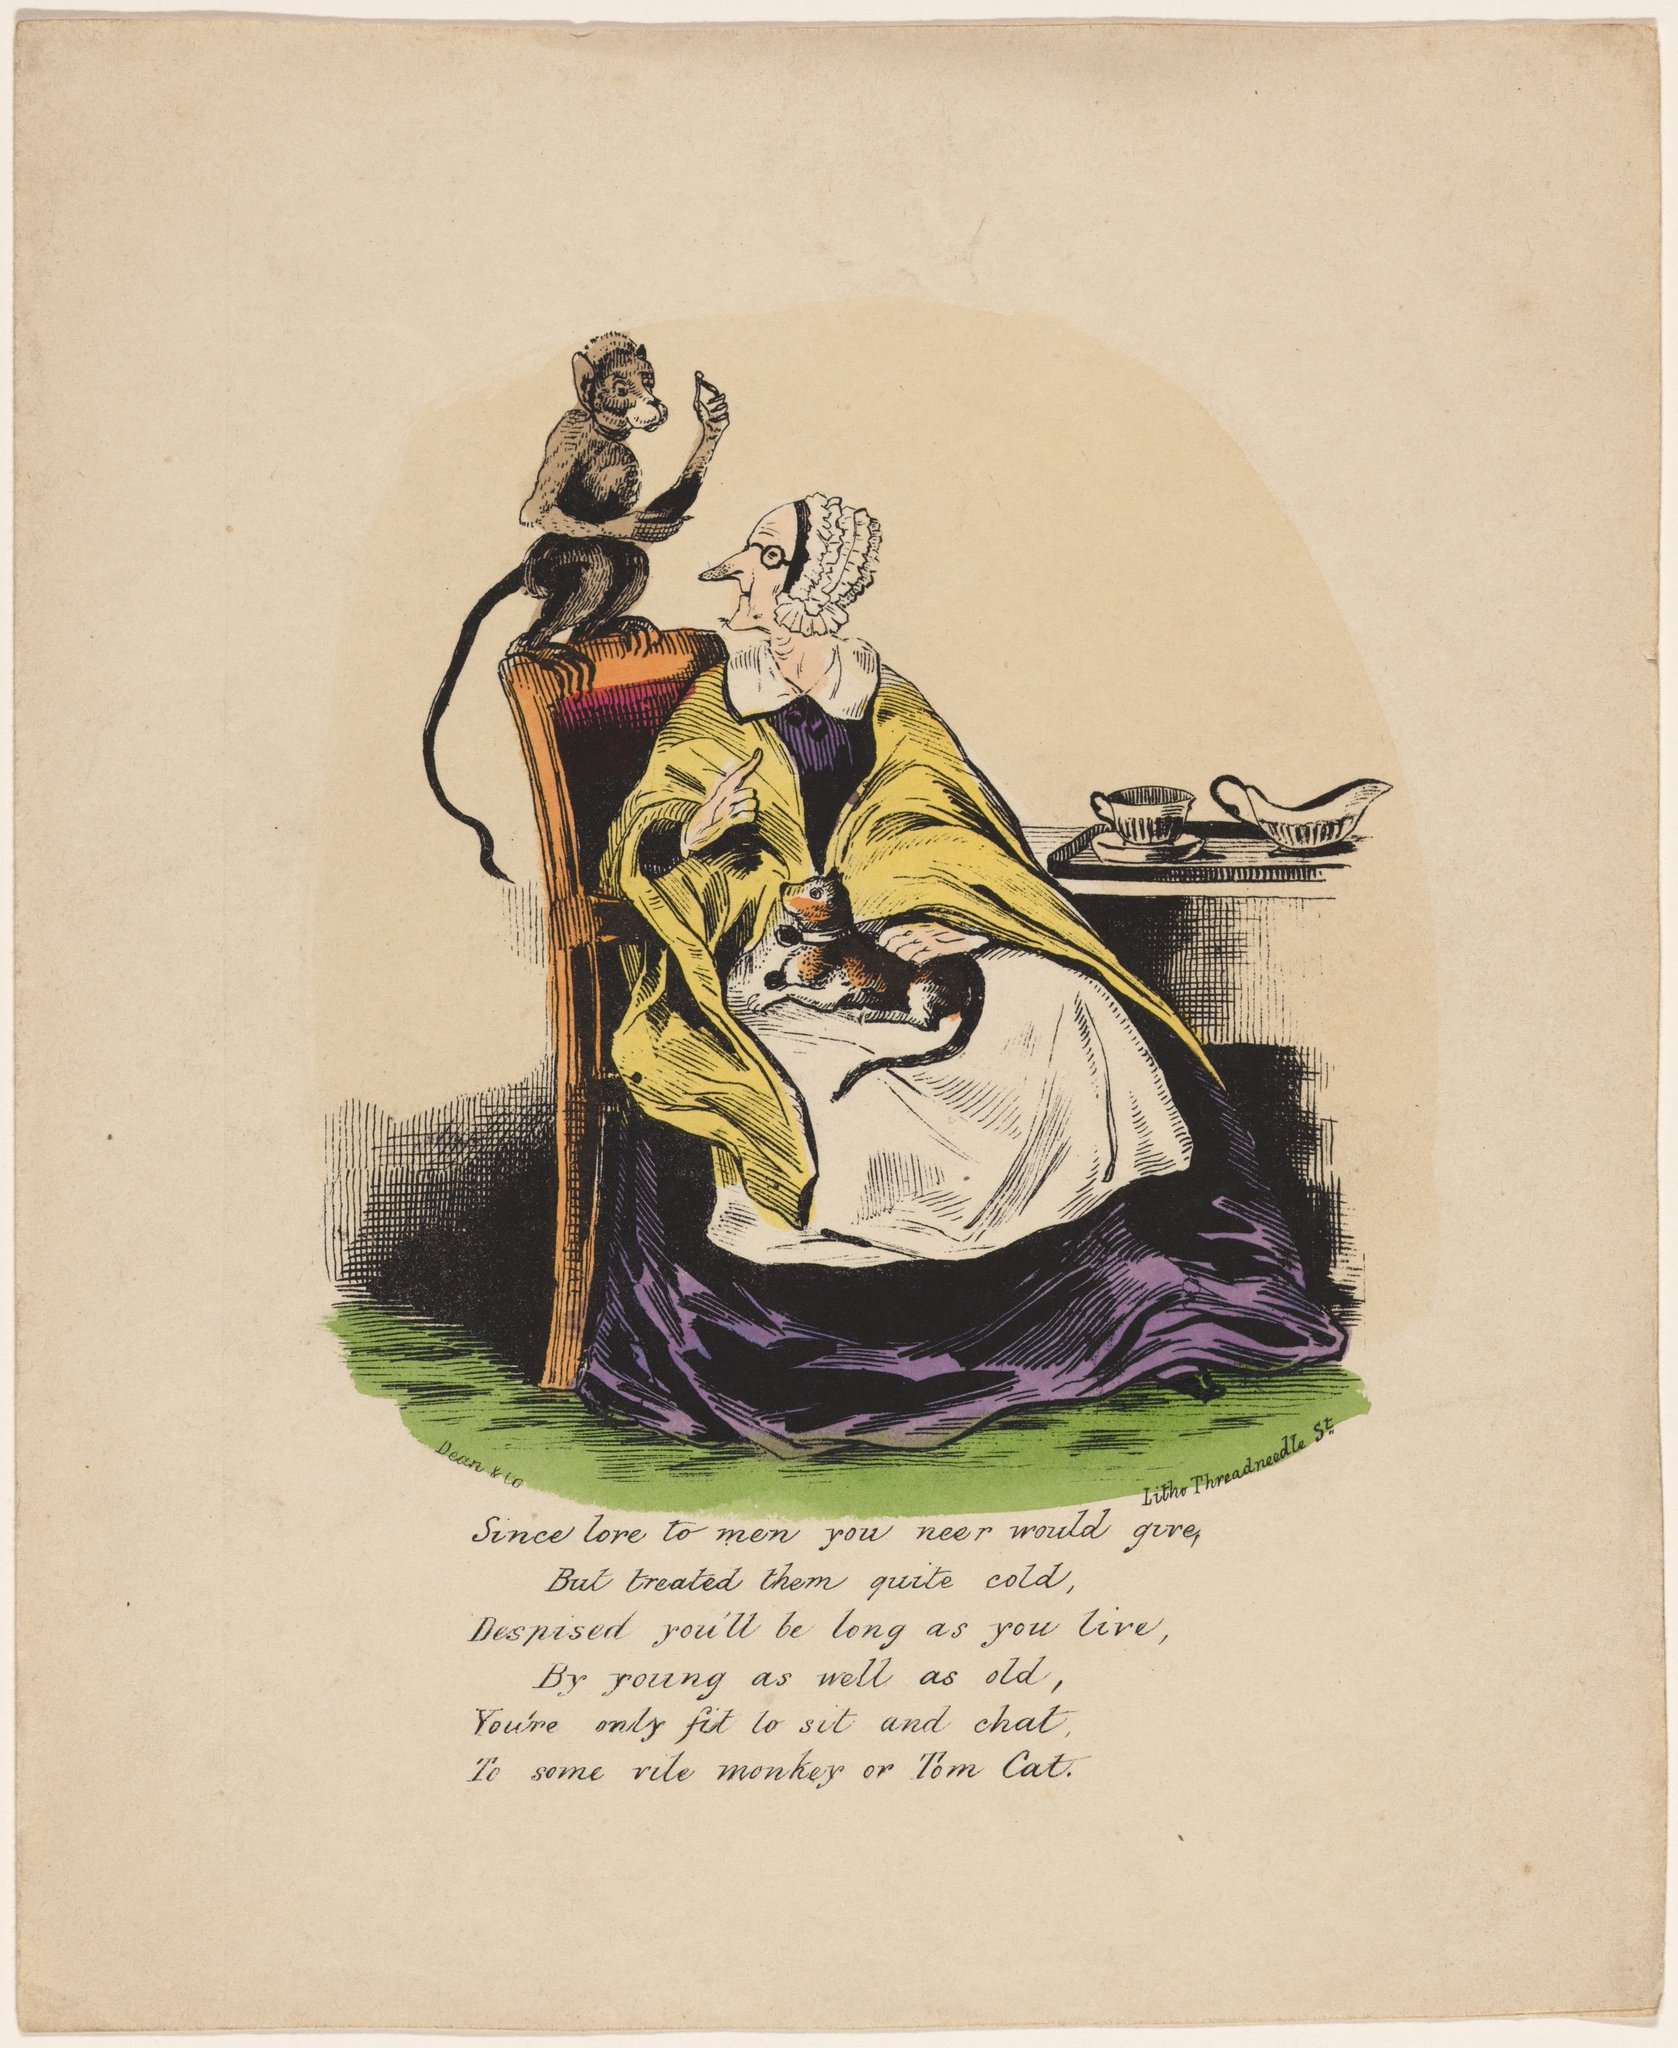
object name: valentine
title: Comic Valentine (Old Maid)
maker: Anonymous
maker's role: artist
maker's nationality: british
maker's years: 1800-1899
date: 1860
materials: watercolor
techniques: hand coloring, lithograph